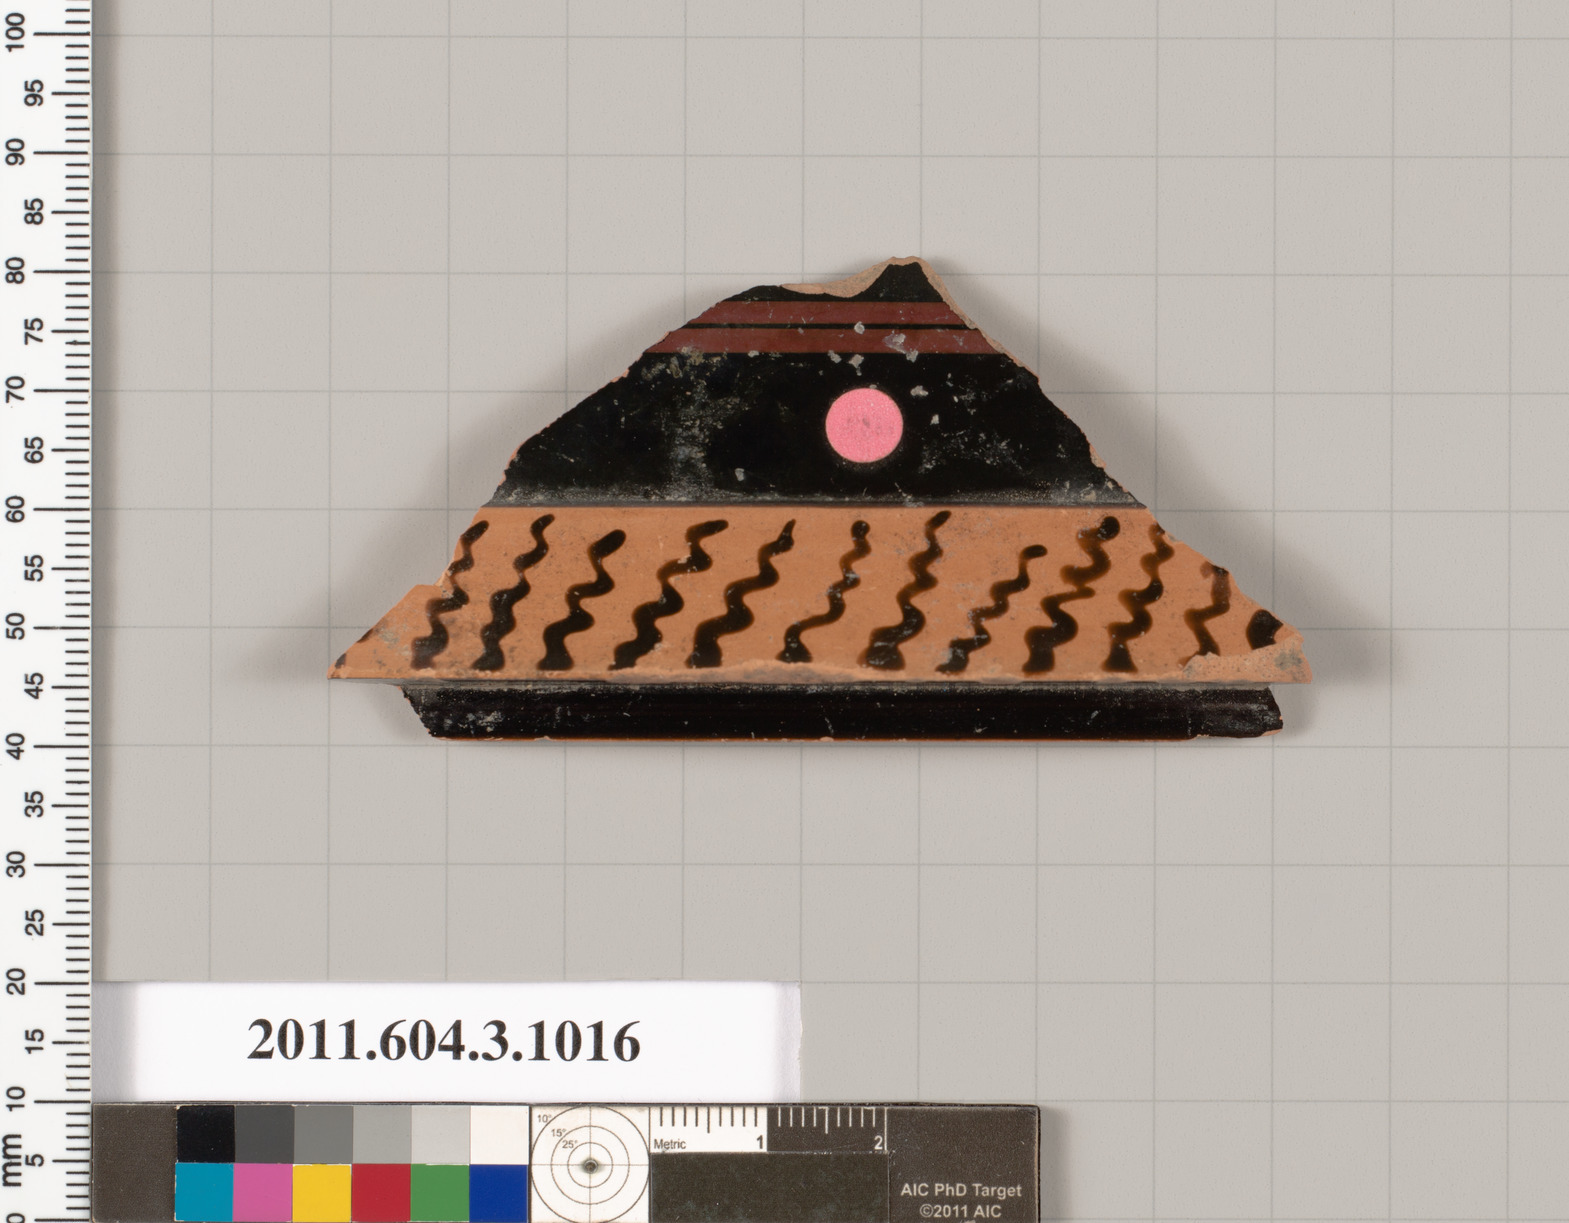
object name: lekanis fragment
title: Terracotta fragment of a lekanis (covered dish)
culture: greek, attic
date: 475-451 BCE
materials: terracotta